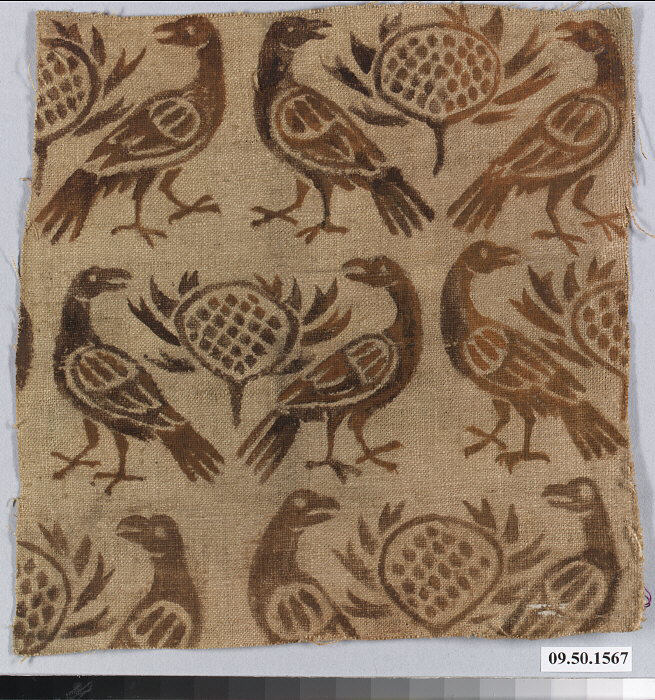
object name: fragment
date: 1101-1200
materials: linen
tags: birds